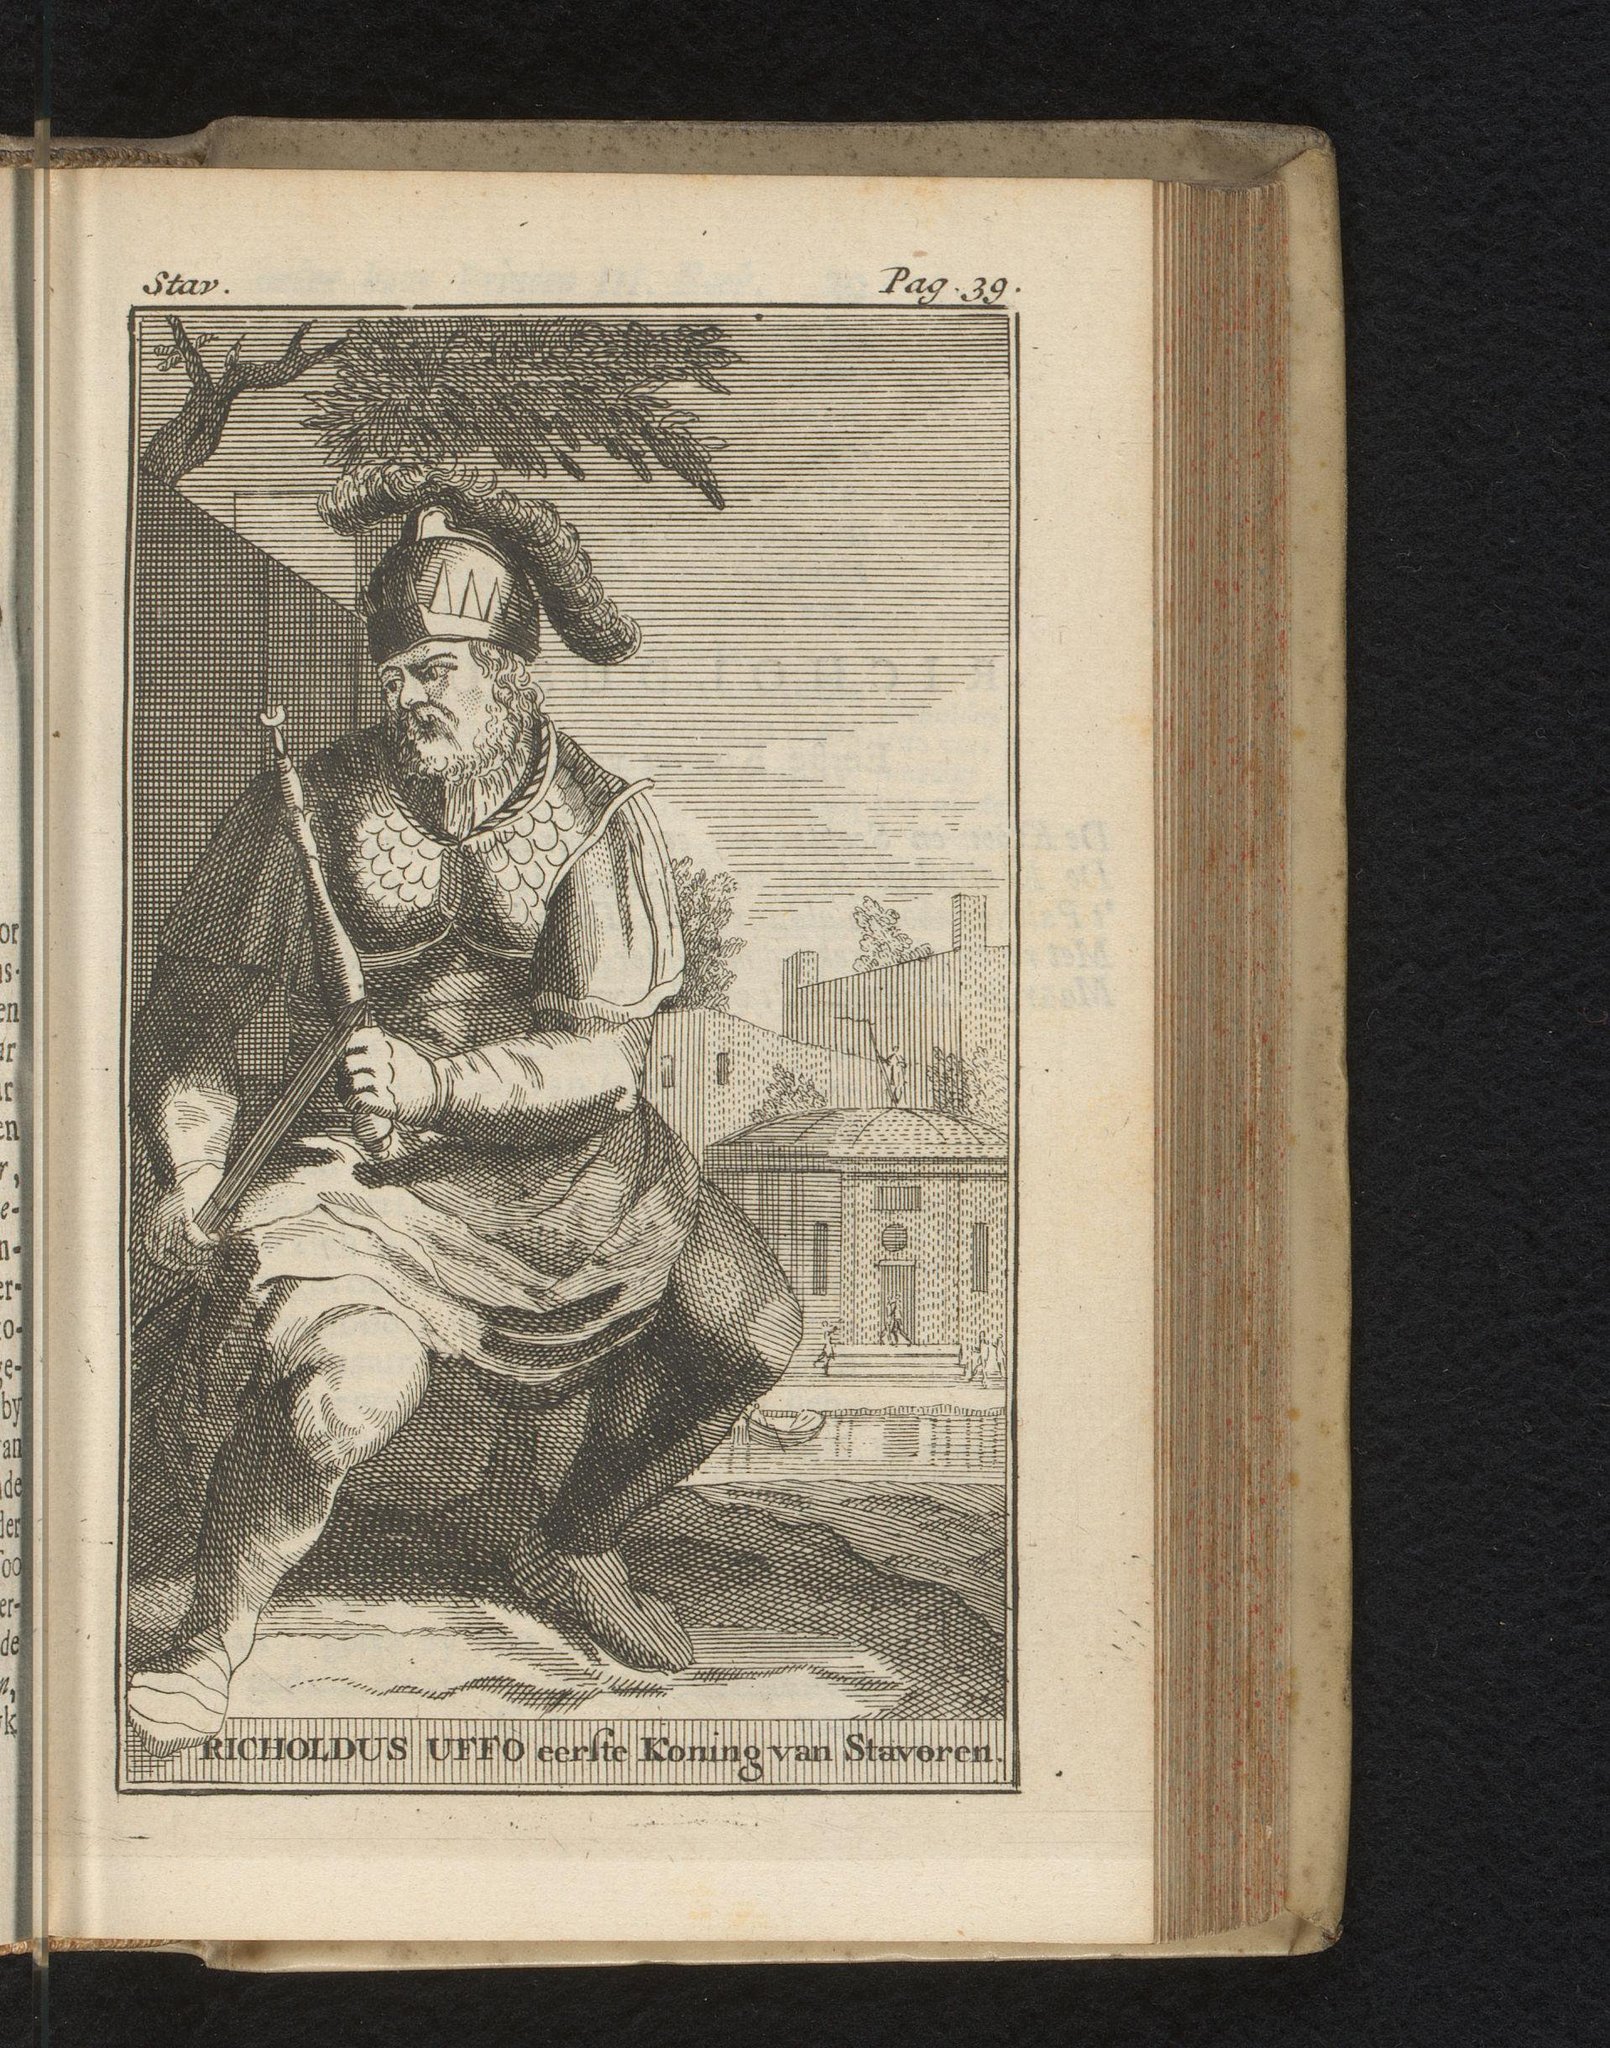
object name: history print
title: Richoldus Uffo eerste Koning van Stavoren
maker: pieter van den berge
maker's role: draughtsman, print maker, printer, publisher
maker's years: 1659-1737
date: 1700-1702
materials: paper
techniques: etching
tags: richold i offo (koning der friezen), stavoren, romeinse periode in nederland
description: Illustratie in: H. Soeteboom, Oud-heden van Zaan-land, Stavoren, Vronen en Waterland : deze laatste druk ... met nodige aanteekeningen, figuren, en een landkaart verrykt / Op- en neder-gank van Stavoren, in VI. Boeken verdeelt, W. Linnig van Koppenol, Amsterdam 1702, ingebonden tussen p. 38/39.